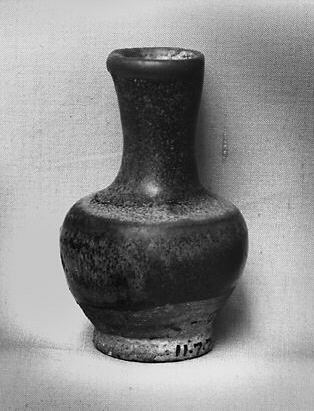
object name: vase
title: Miniature vase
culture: chinese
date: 801-900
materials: glaze, stoneware